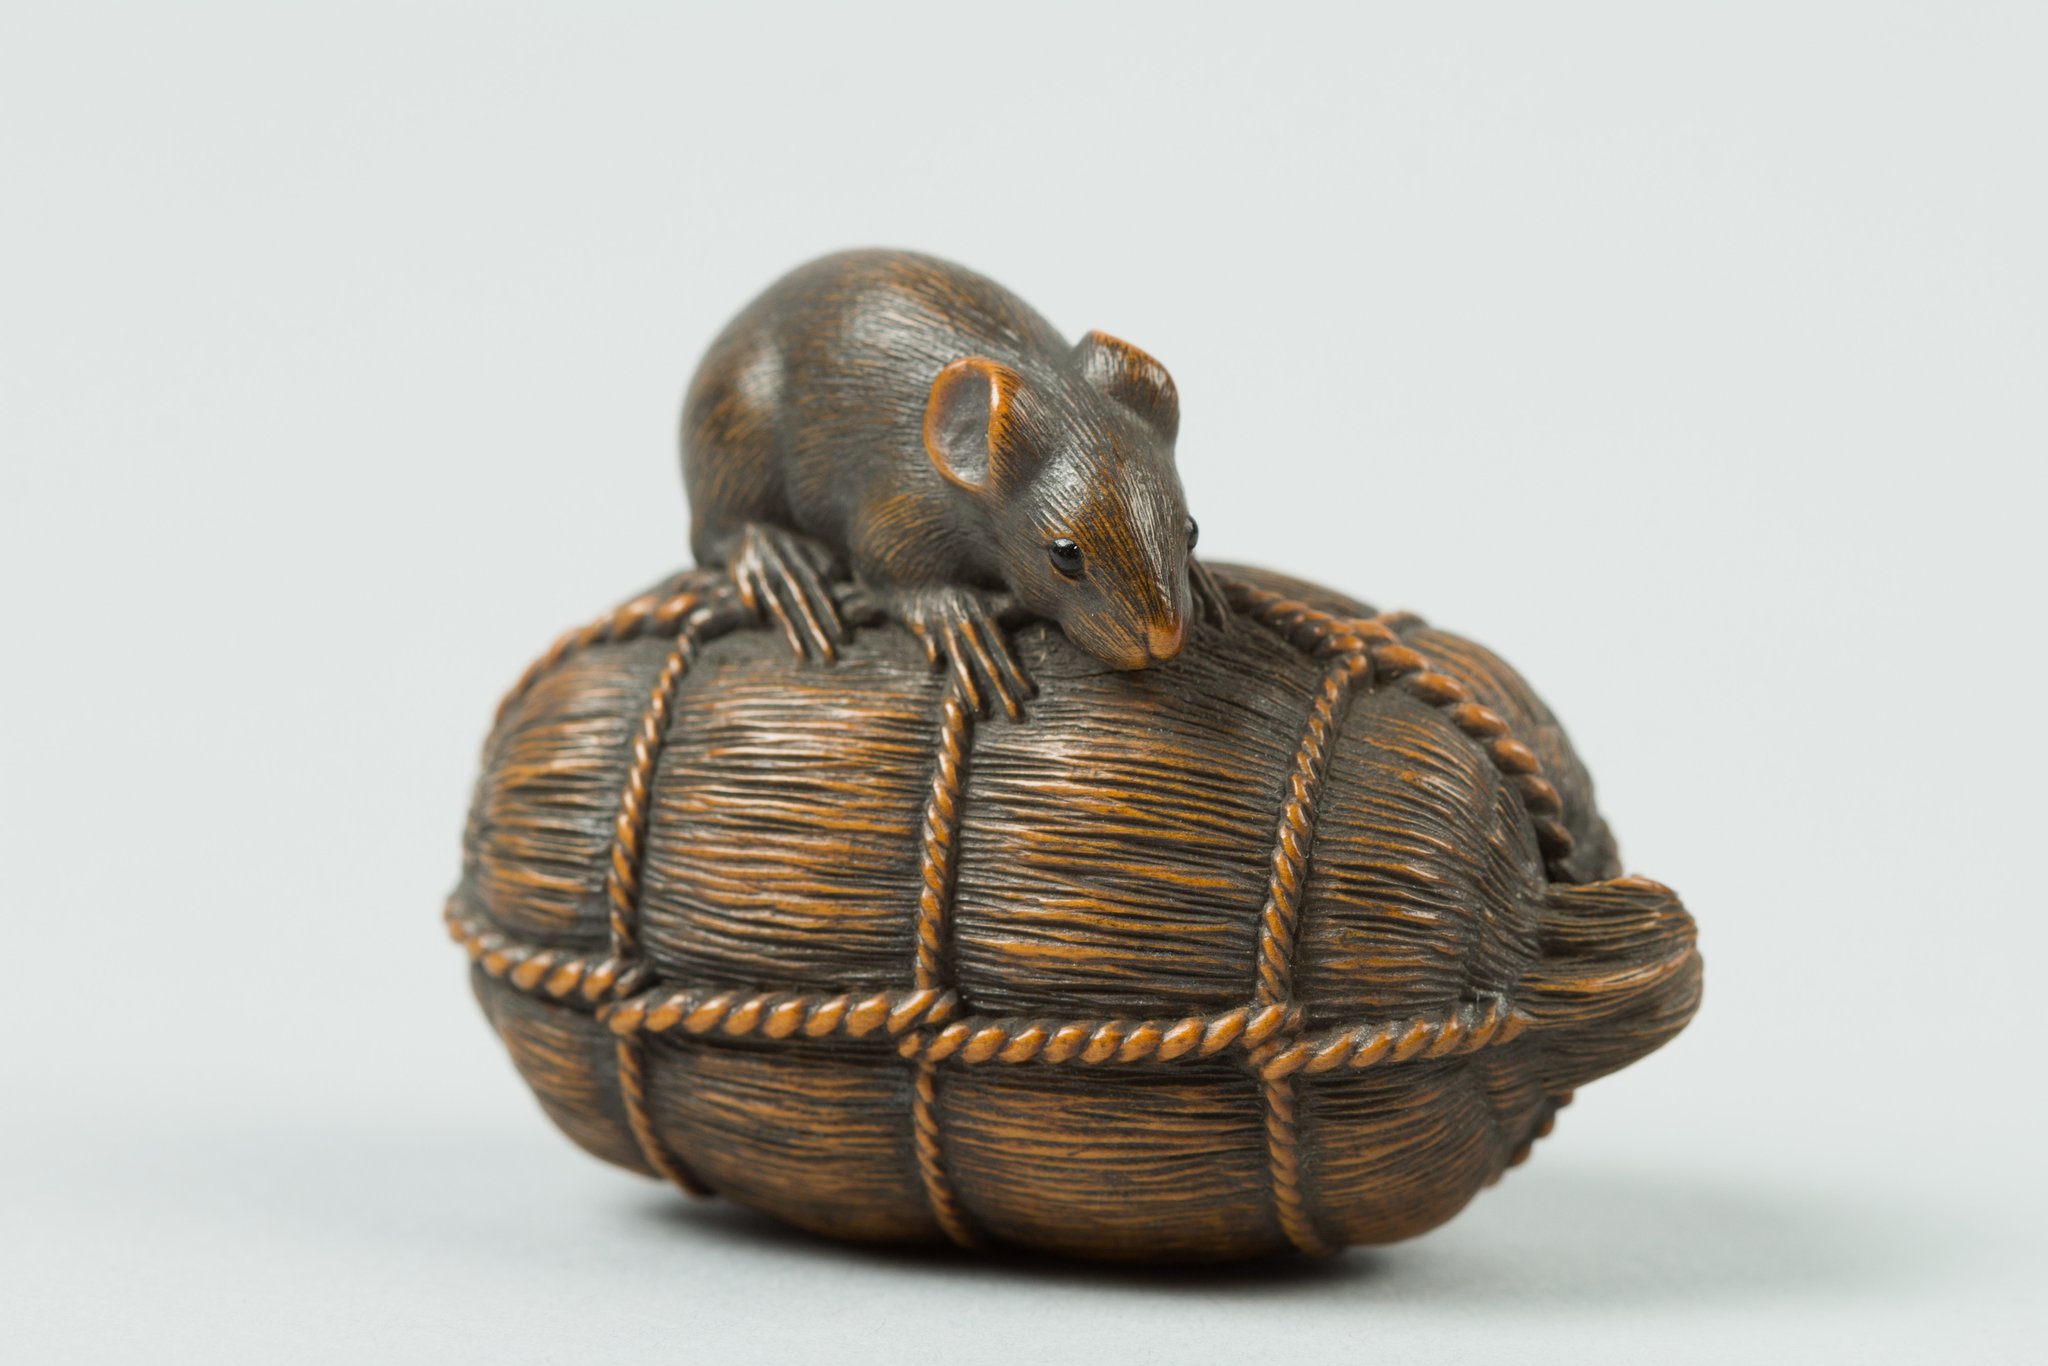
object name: netsuke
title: Netsuke of Rat on a Bale of Rice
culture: japanese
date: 1834-1866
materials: wood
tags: mice,rats